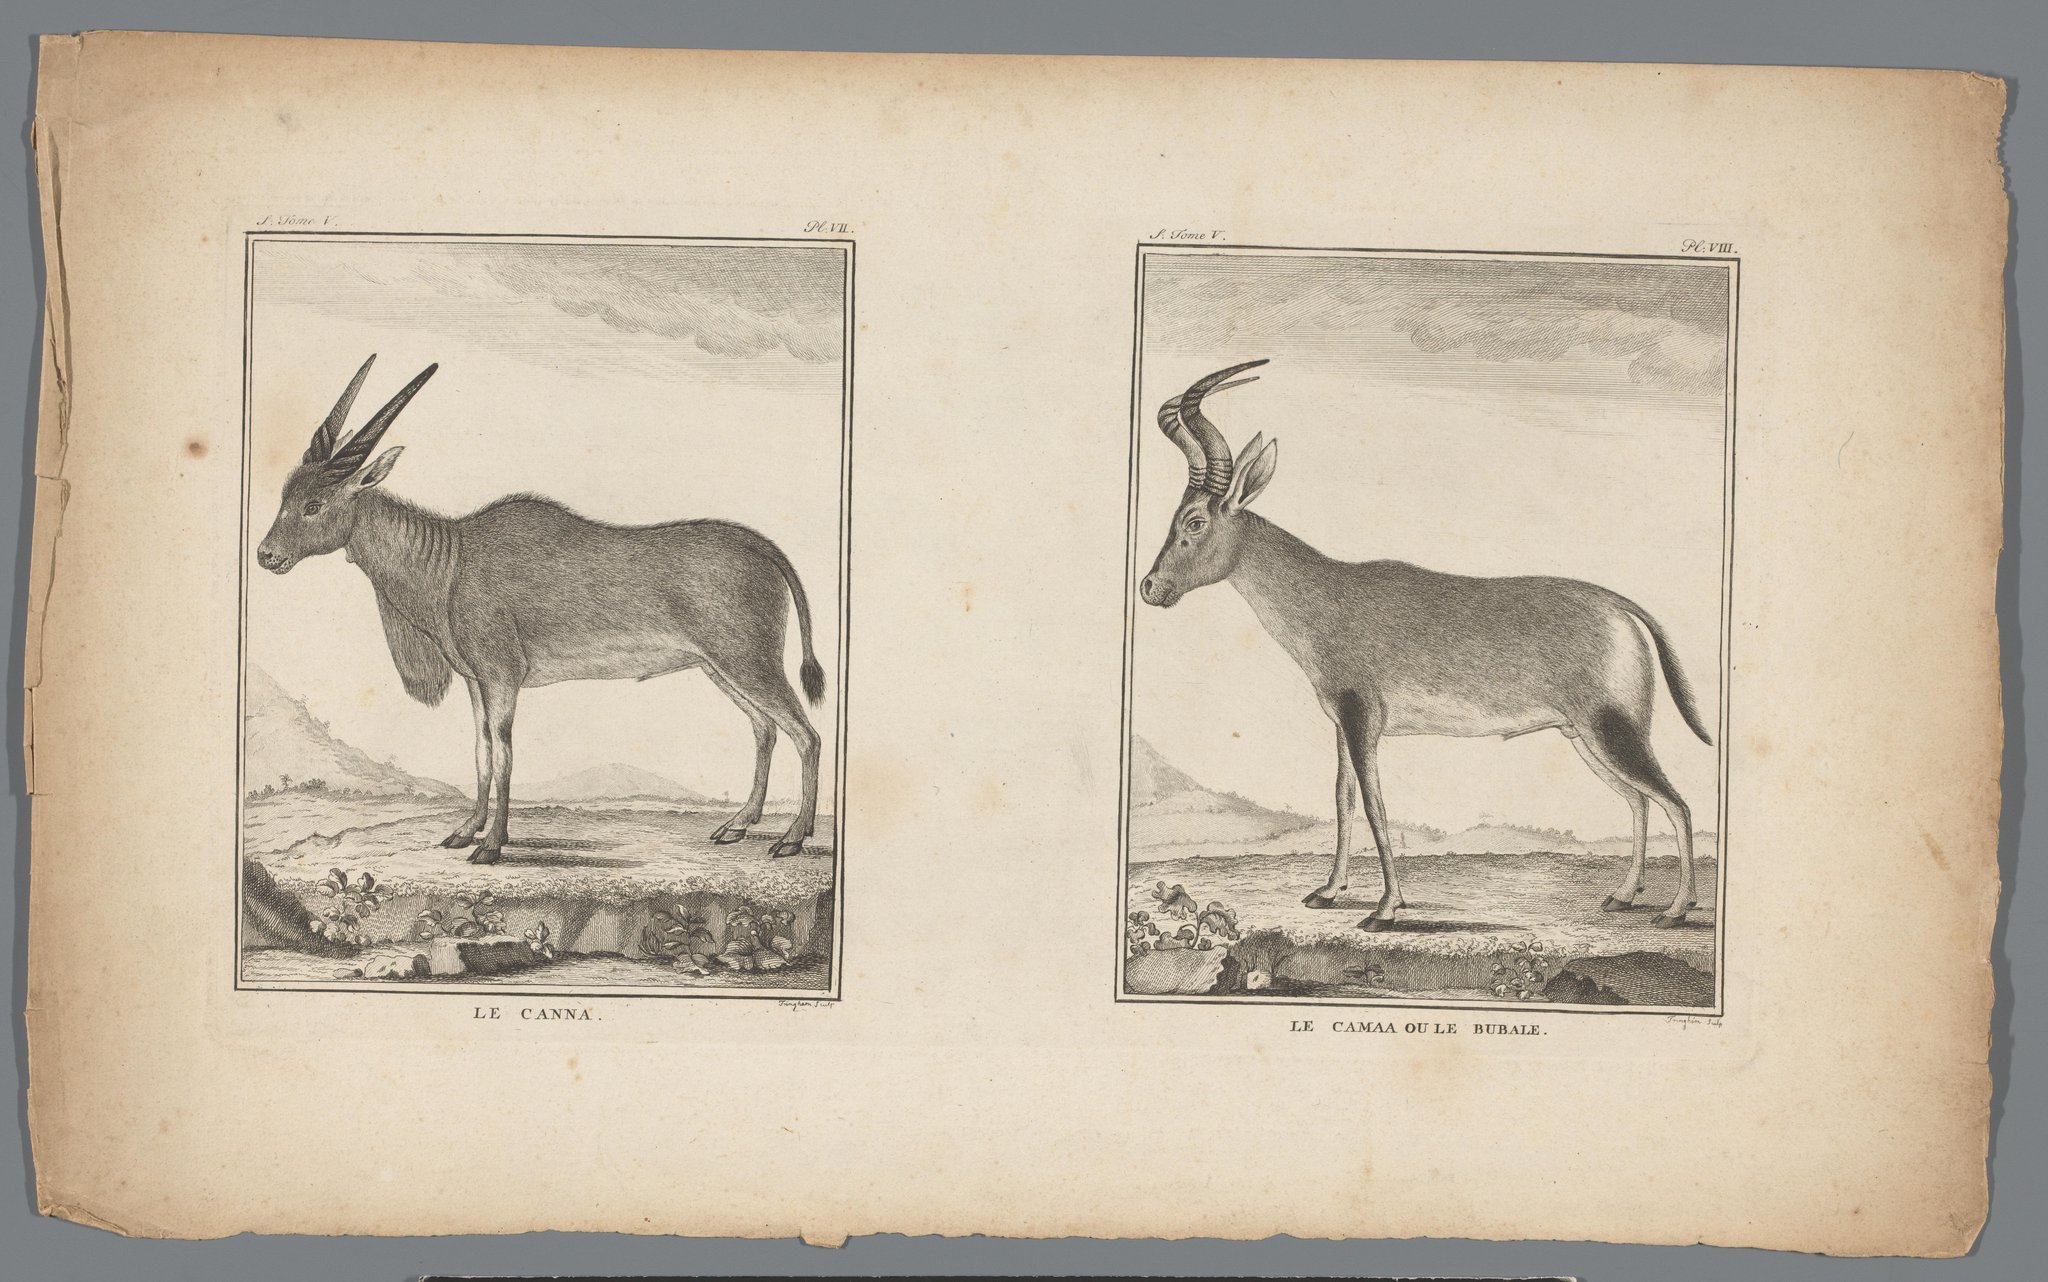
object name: print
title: Le Canna / le Camaa ou le Bubale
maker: w. tringham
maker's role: print maker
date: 1781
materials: paper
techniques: engraving, etching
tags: hoofed animals: antelope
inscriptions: label: ‘B4’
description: Gebruikt als boekillustratie in: van G.L. Leclerc de Buffon en L.J.M. Daubenton, bewerkt door J.N.S. Allamand, Histoire Naturelle (Nouvelle Edition bewerkt door J.N.S. Allamand), Amsterdam: J.H. Schneider, 1766-1799, supplement V (1781).